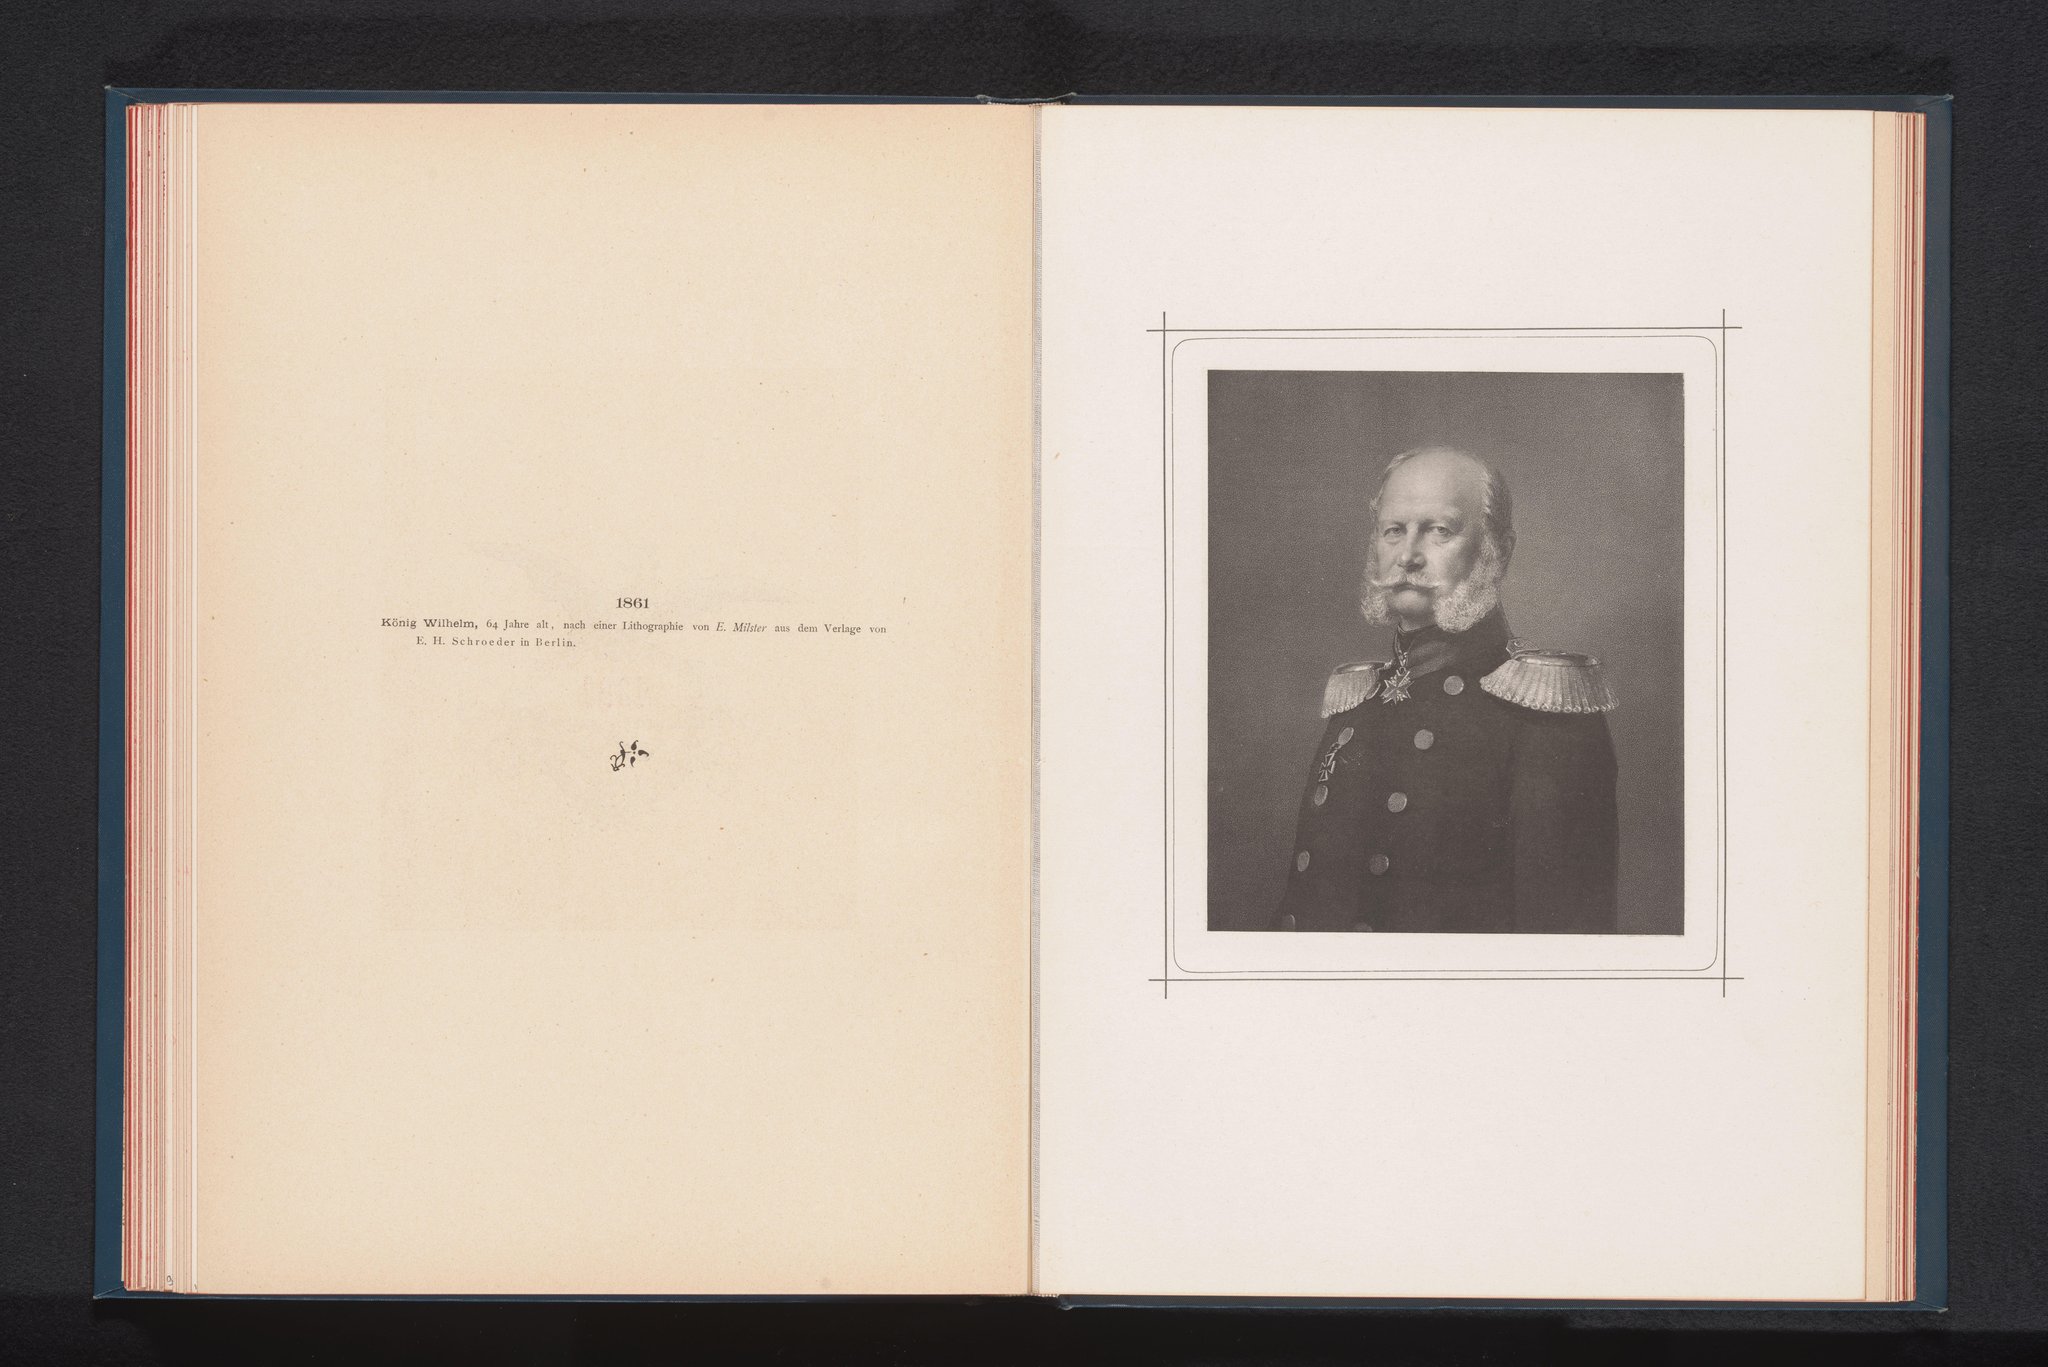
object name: page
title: Fotoreproductie van een portret van Wilhelm I op een leeftijd van 64 jaar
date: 1887-1897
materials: paper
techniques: photograph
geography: germany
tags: berlin, wilhelm i (keizer van duitsland), ruler, sovereign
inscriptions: inscription: ‘1861 König Wilhelm, 64 Jahre alt, nach einer lithographie von E. Milster aus dem Verlage von E.H. Schroeder in Berlin.’